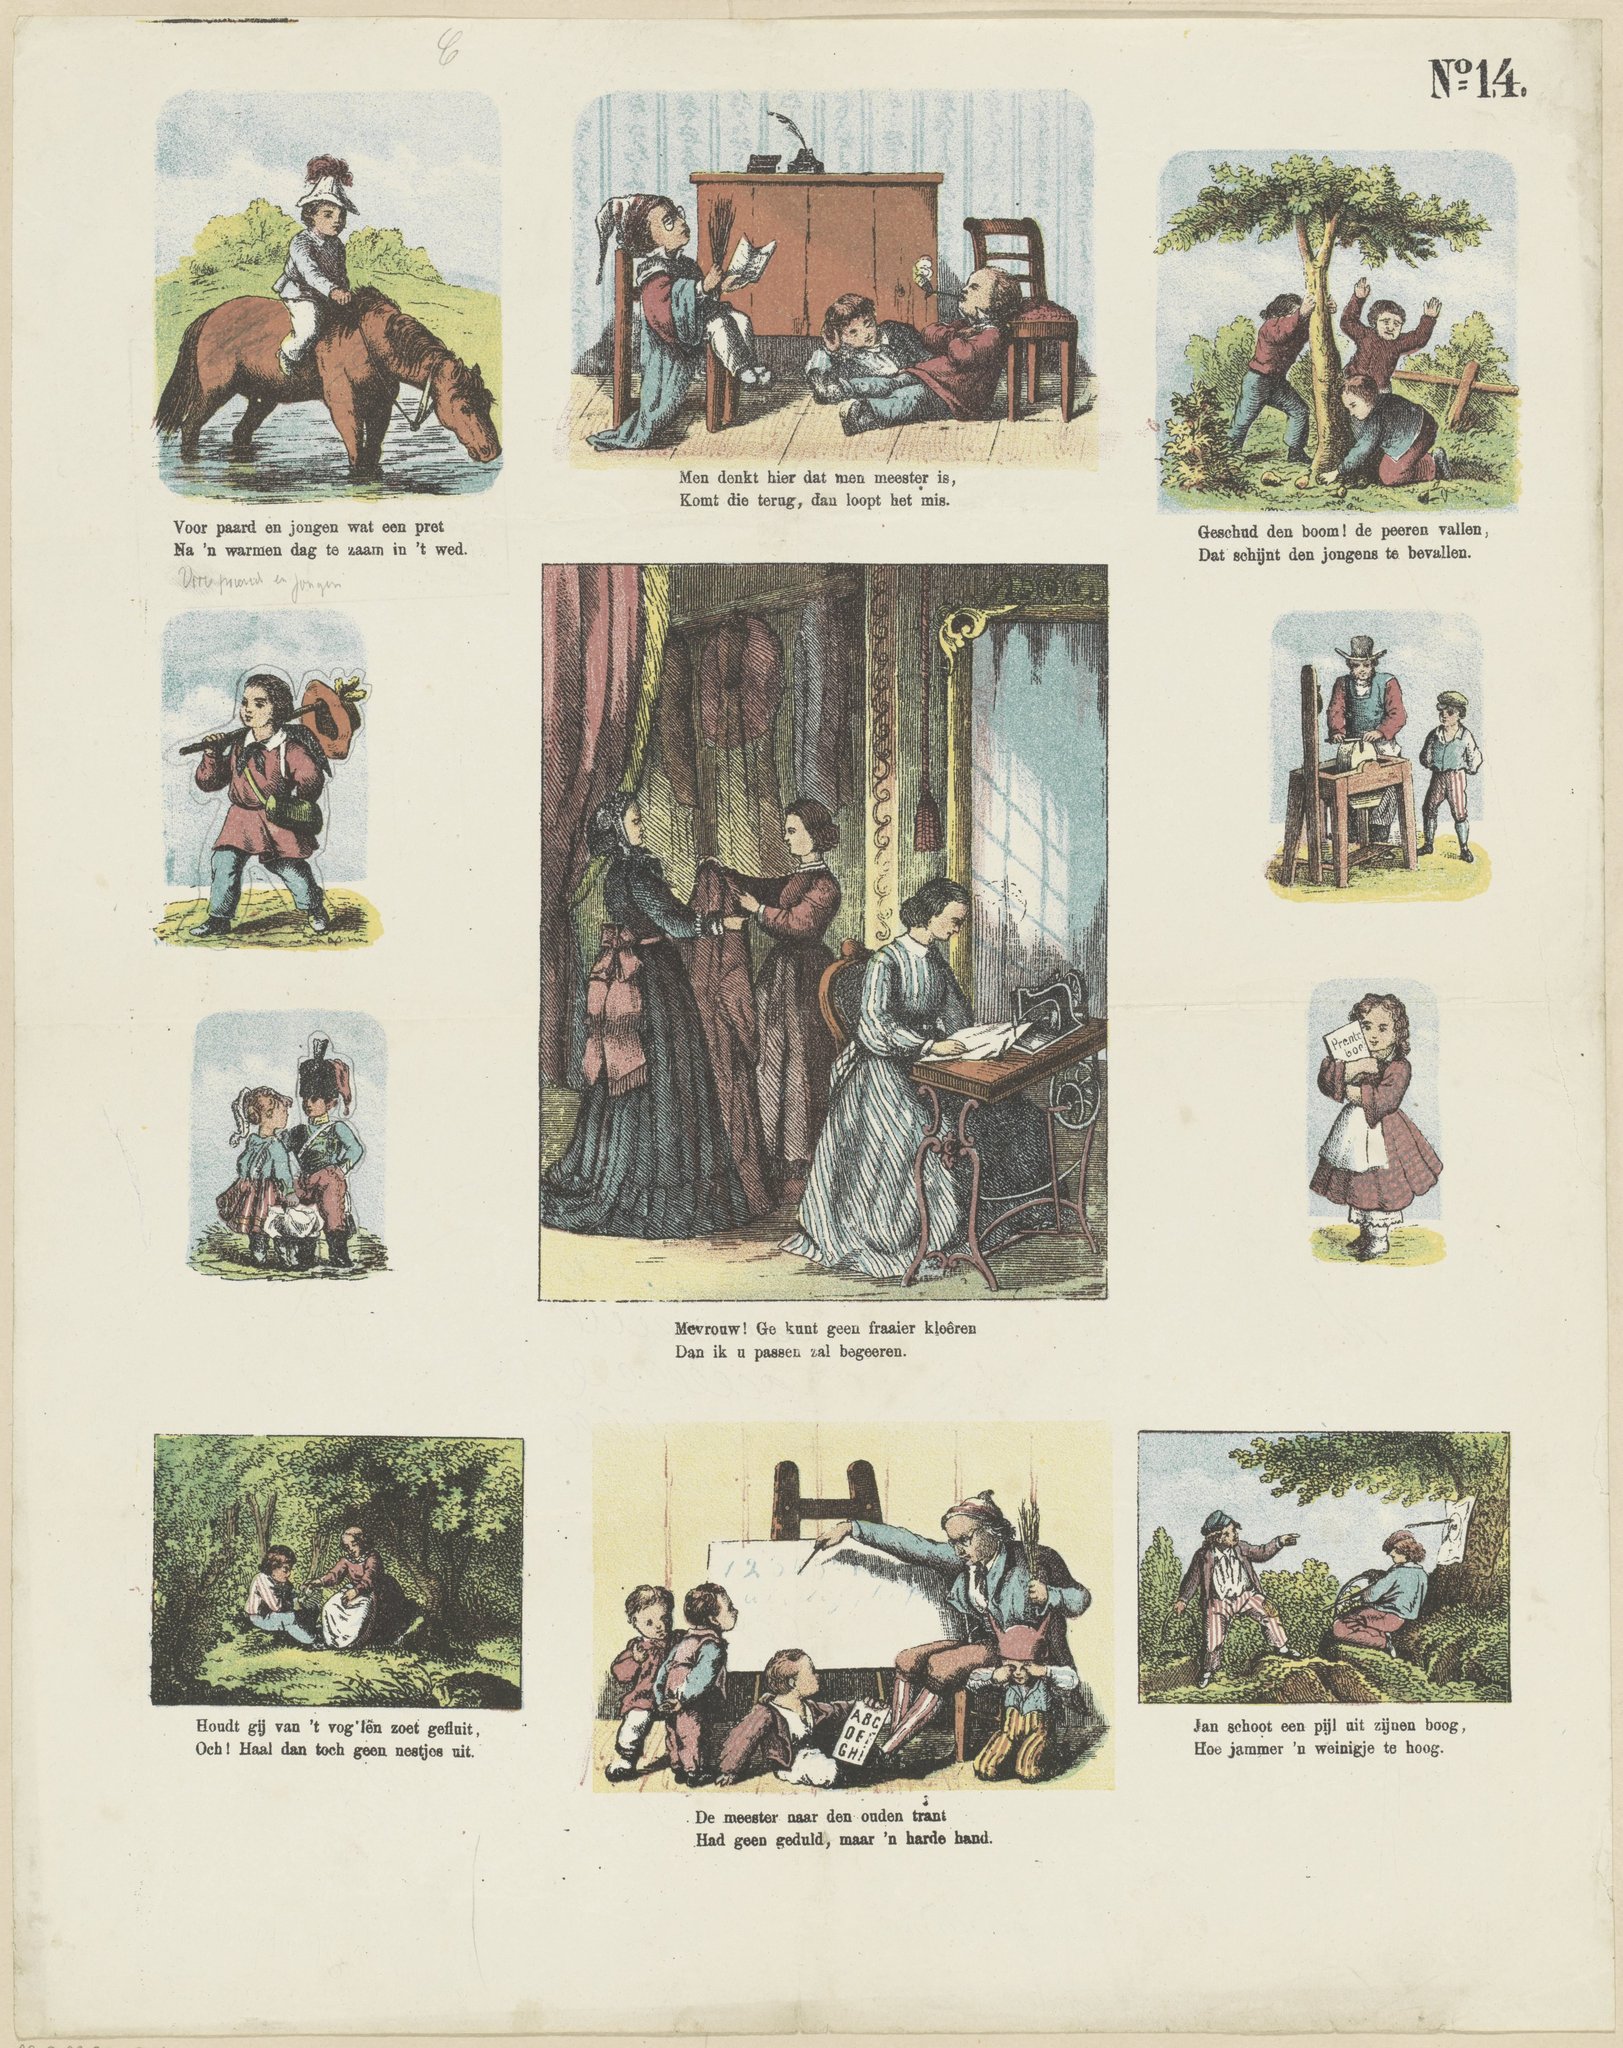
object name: popular print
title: Meijer's prenten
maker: Anonymous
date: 1873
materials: paper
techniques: lithograph, letterpress printing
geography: amsterdam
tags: riding a horse, ass, or mule; rider, horseman, education, science and learning, children's games and plays, child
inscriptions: inscription, collector's mark: Lugt 2760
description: Blad met 11 voorstellingen van verschillende aard, waaronder een jongen te paard, luiwammesen, peren oogsten, een naaister en schieten met pijl en boog. Onder enkele afbeeldingen een tweeregelig vers. Genummerd rechtsboven: No. 14.